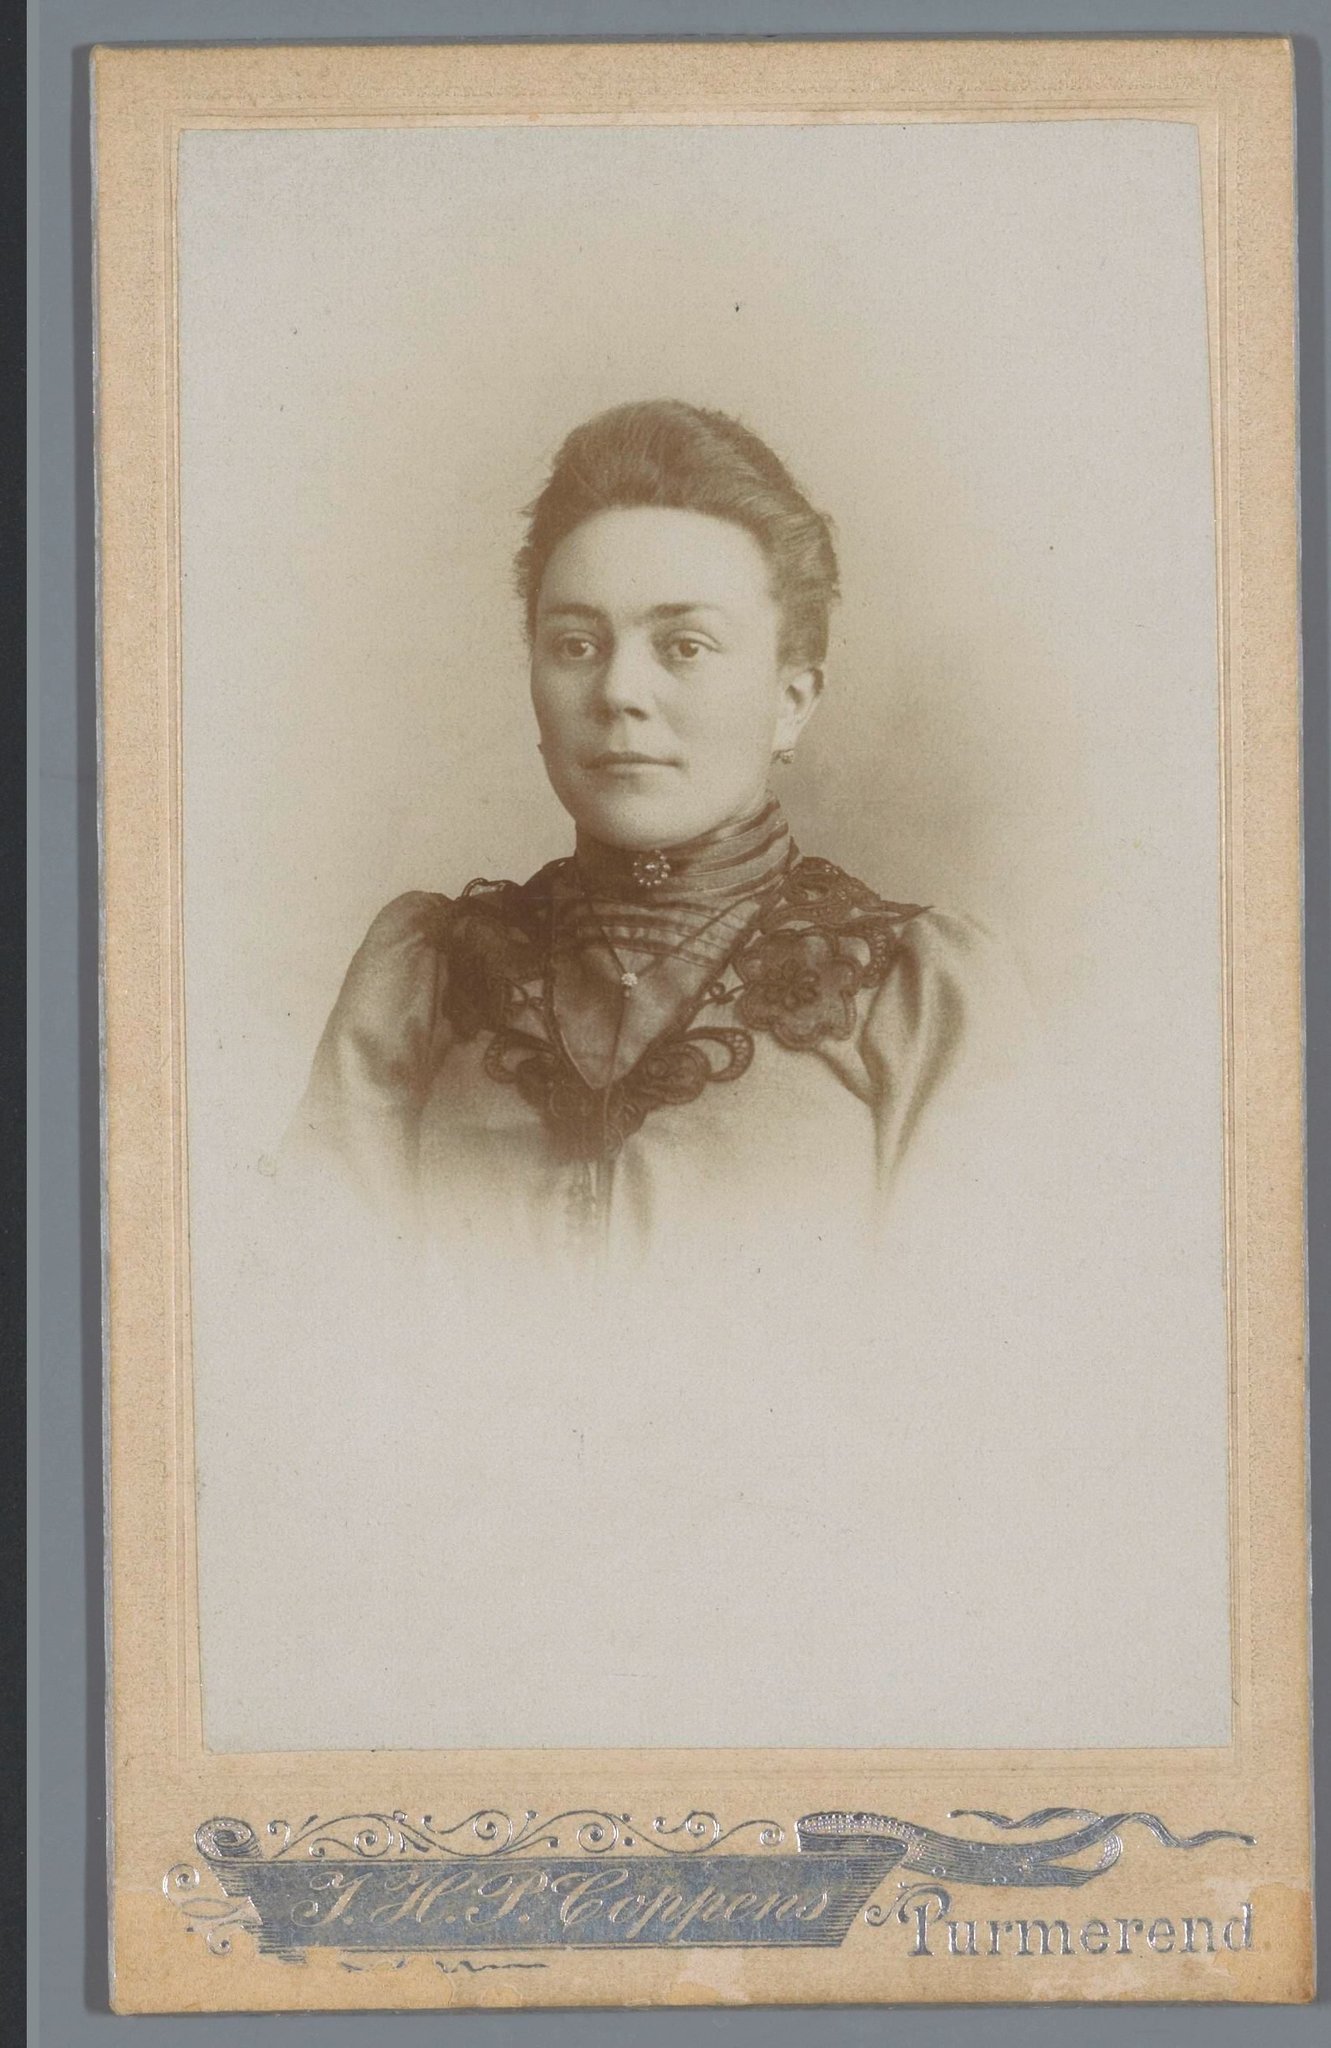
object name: carte de visite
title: Portret van Jouwertje Koster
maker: josephus hendrikus petrus coppens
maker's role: fotograaf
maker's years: 1864-1941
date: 1900-1910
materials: cardboard, photographic support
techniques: gelatin silver print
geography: purmerend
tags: koog aan de zaan, historical persons - bb - woman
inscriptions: inscription: ‘Levensgroote olieverfs/ Pastell en Craijon/ Portretten naar/ Photographie/ J. H. P. Coppens/ Photograaf/ en/ Portretschilder/ Purmerend./ Negatieven voor nabestelling bewaard’, inscription: ‘Jouwertje Koster’